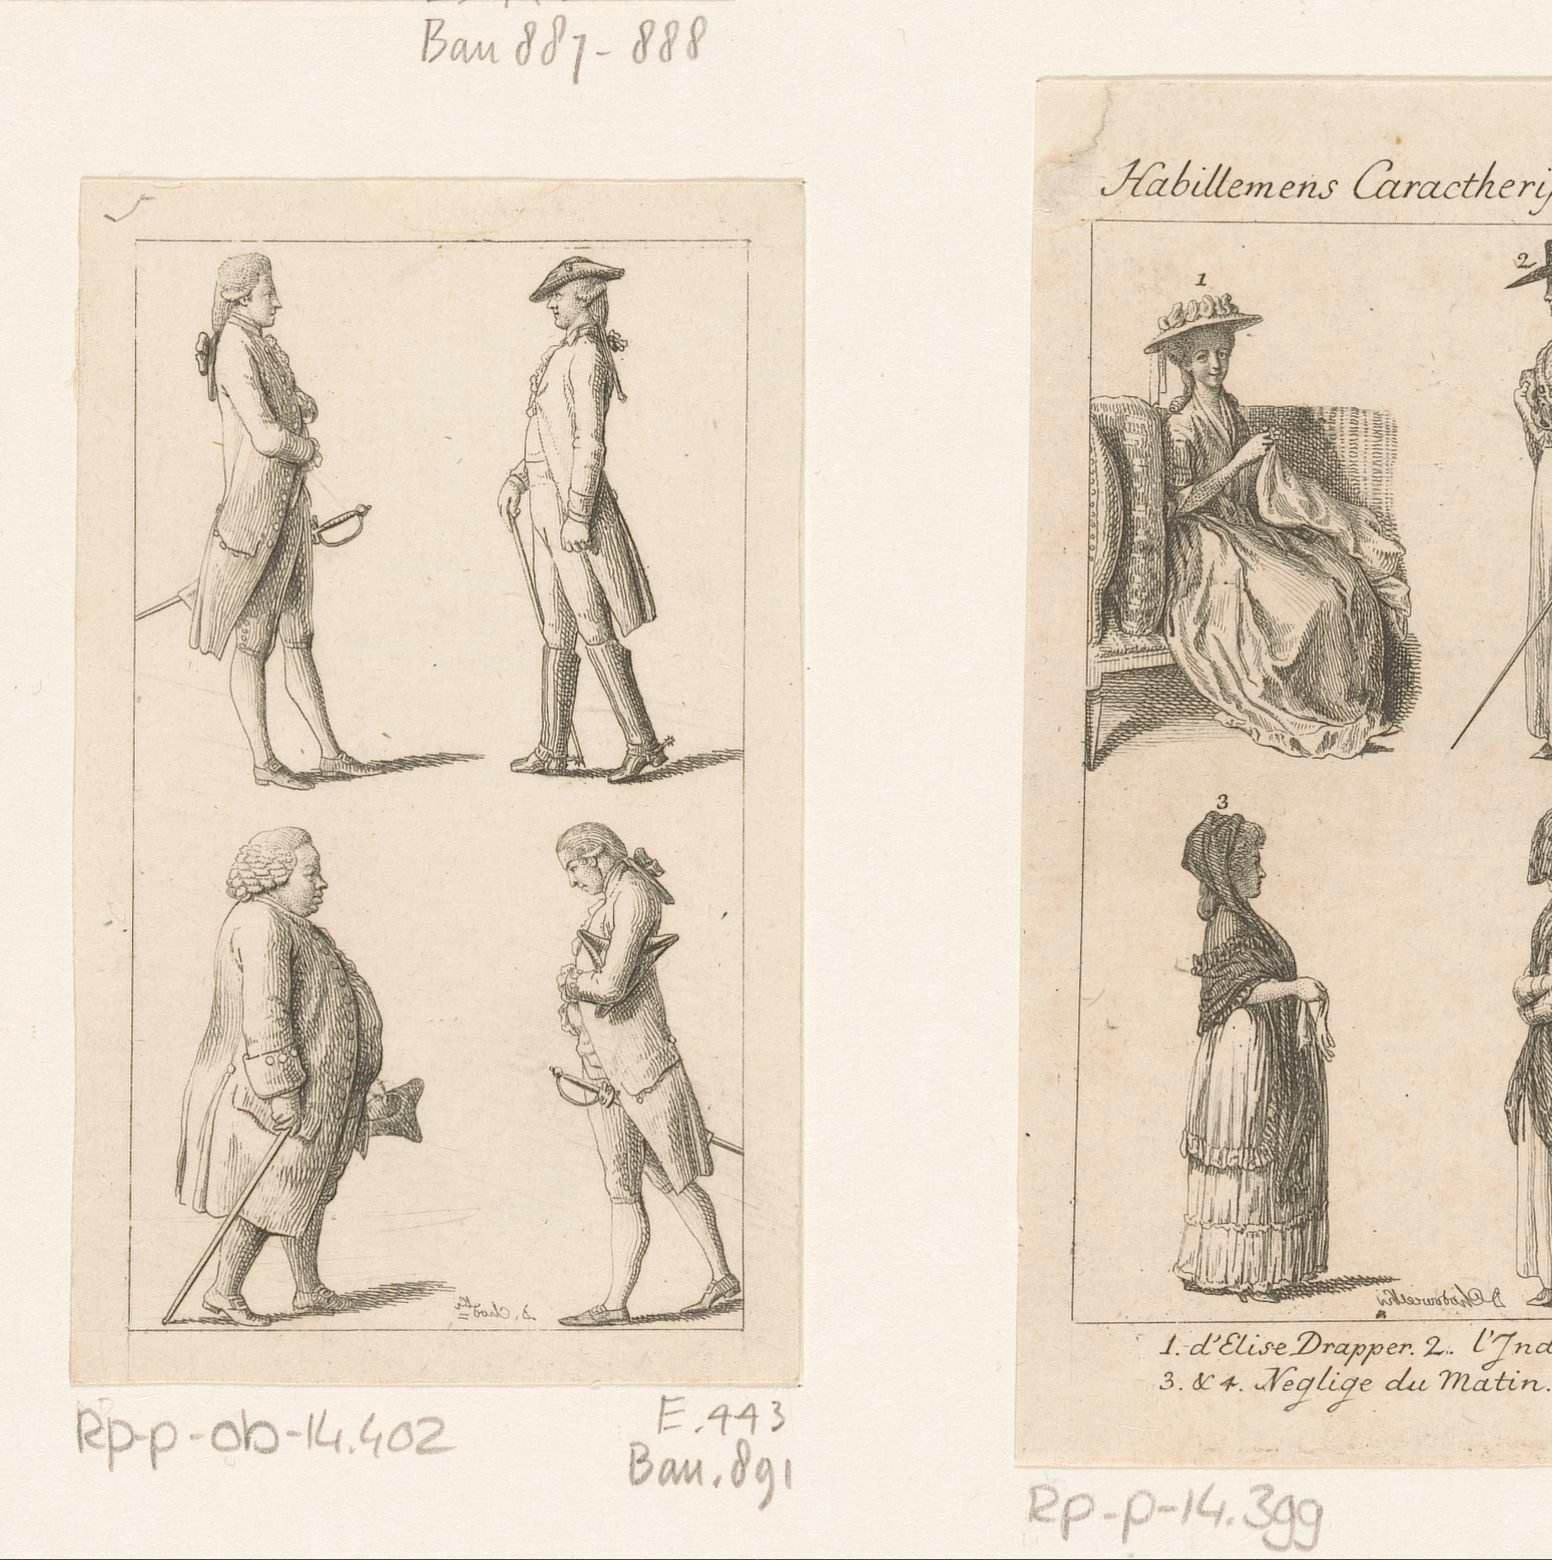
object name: print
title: Kleding voor heren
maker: daniel nikolaus chodowiecki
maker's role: draughtsman, print maker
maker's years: 1726-1801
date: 1782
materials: paper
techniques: etching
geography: berlin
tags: fashion, clothing, clothes for special purposes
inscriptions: collector's mark: Lugt 2228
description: Prent gebruikt voor: Köningl. Grosbr. Genealogischer Kalender auf das 1783 Jahr. Lauenburg: J. G. Berenberg, 1782.